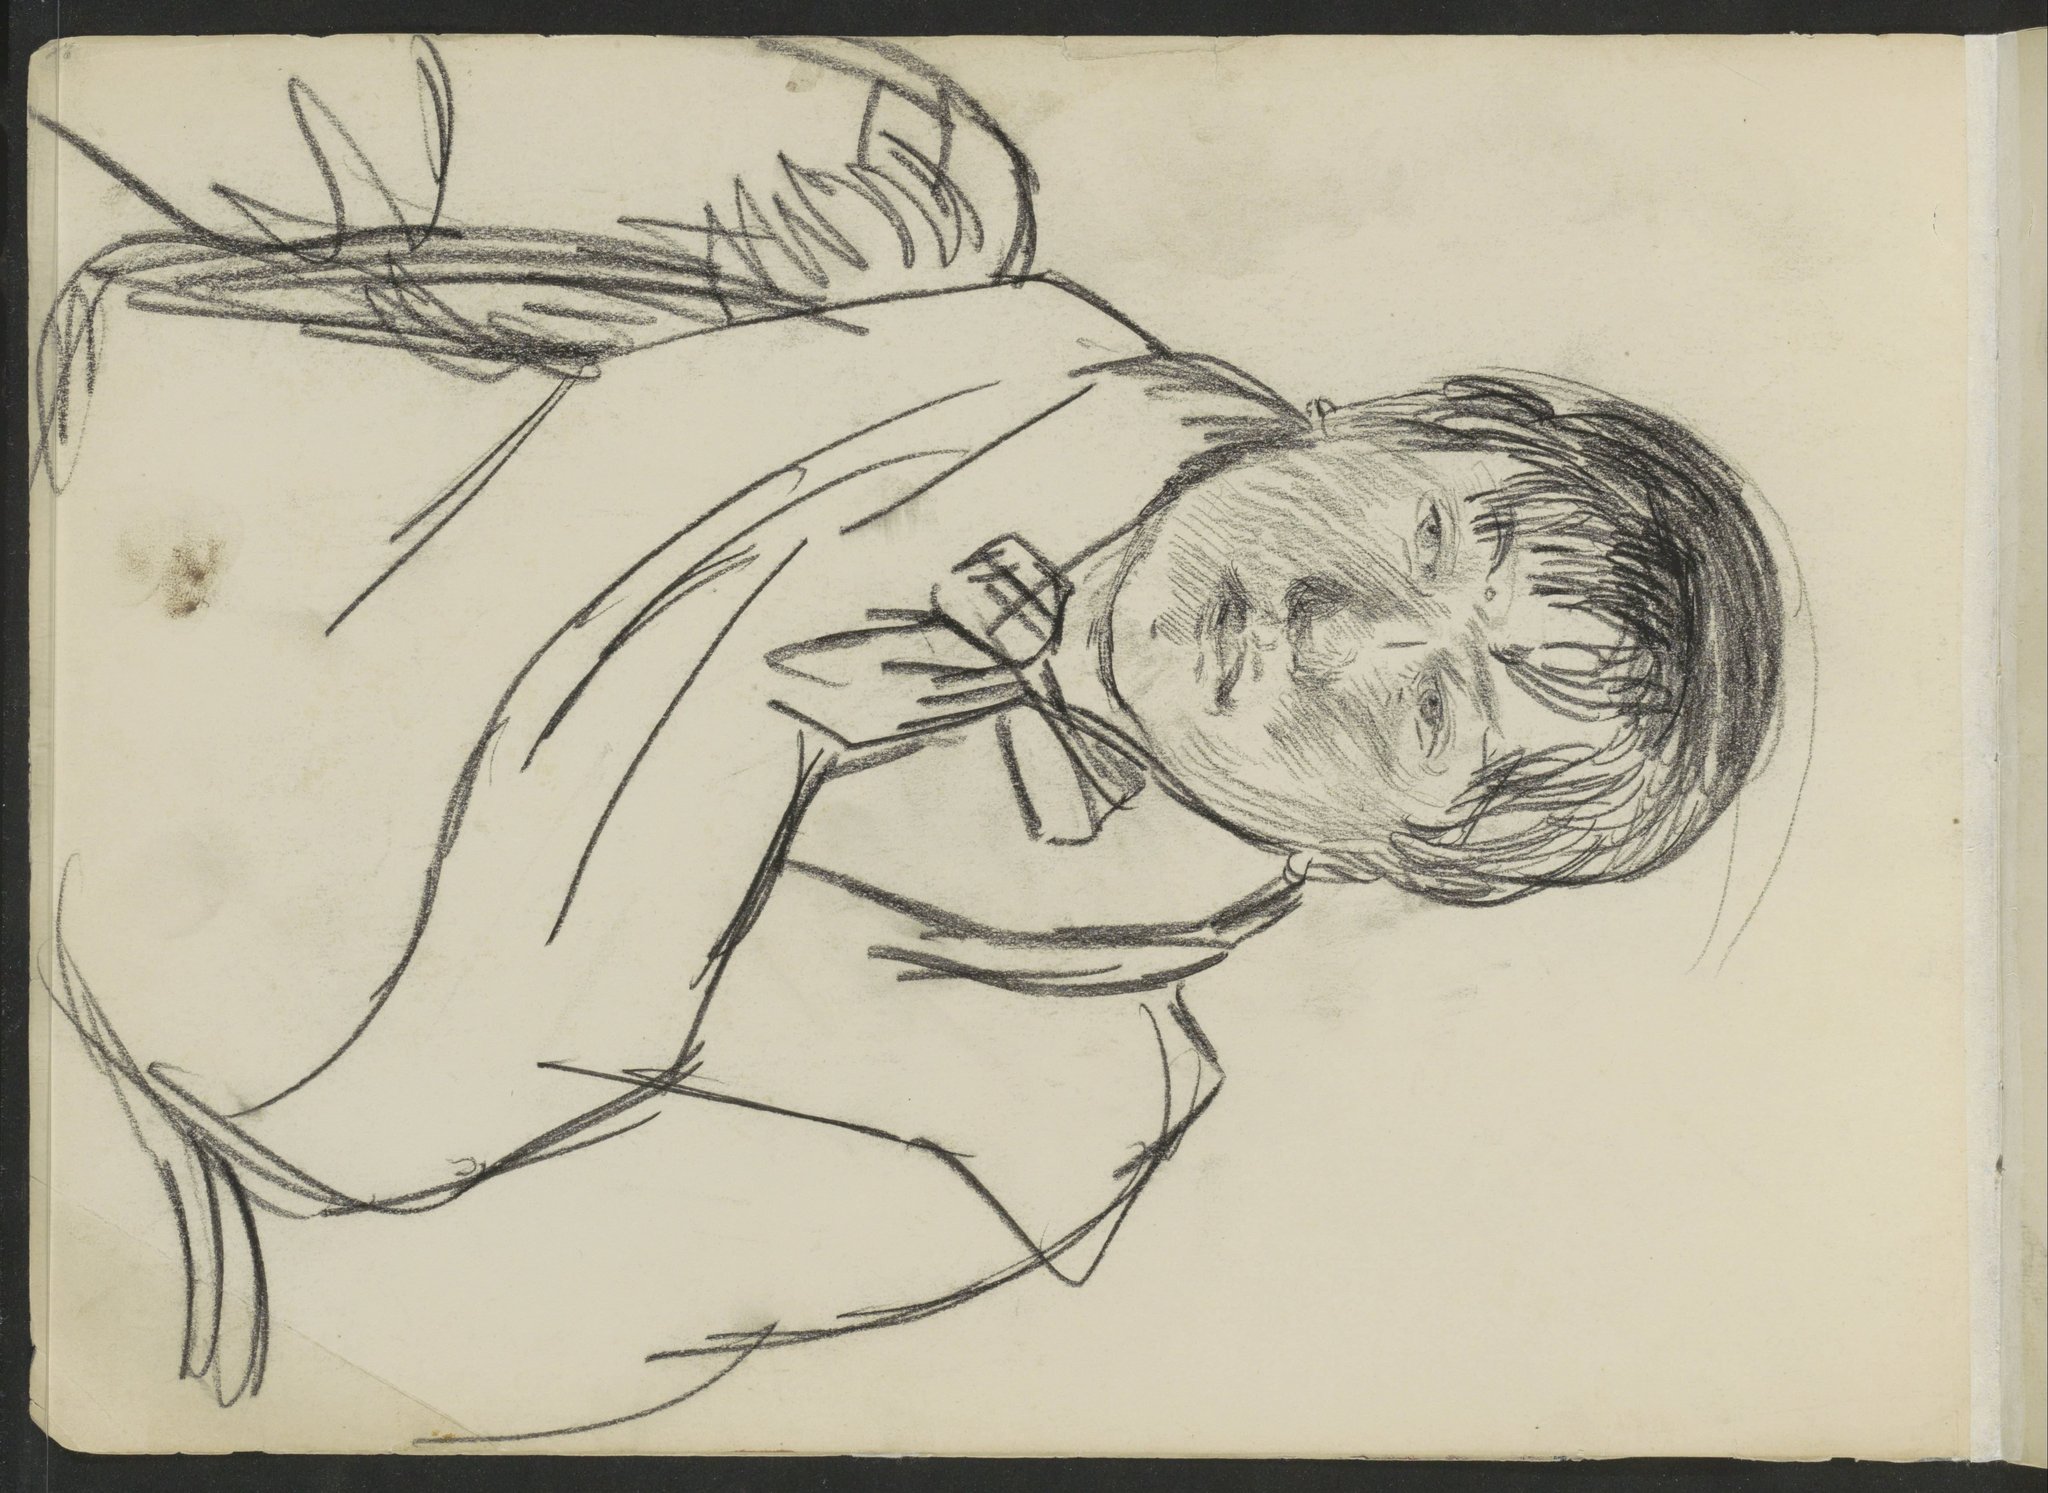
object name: sketchbook leaf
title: Portret van een onbekende vrouw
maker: isaac israels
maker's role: draughtsman, painter, print maker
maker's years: 1865-1934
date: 1886-1934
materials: chalk, paper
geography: amsterdam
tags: adult woman, hands folded with fingers knit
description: Blad 1 verso uit schetsboek LXVII met 11 bladen.